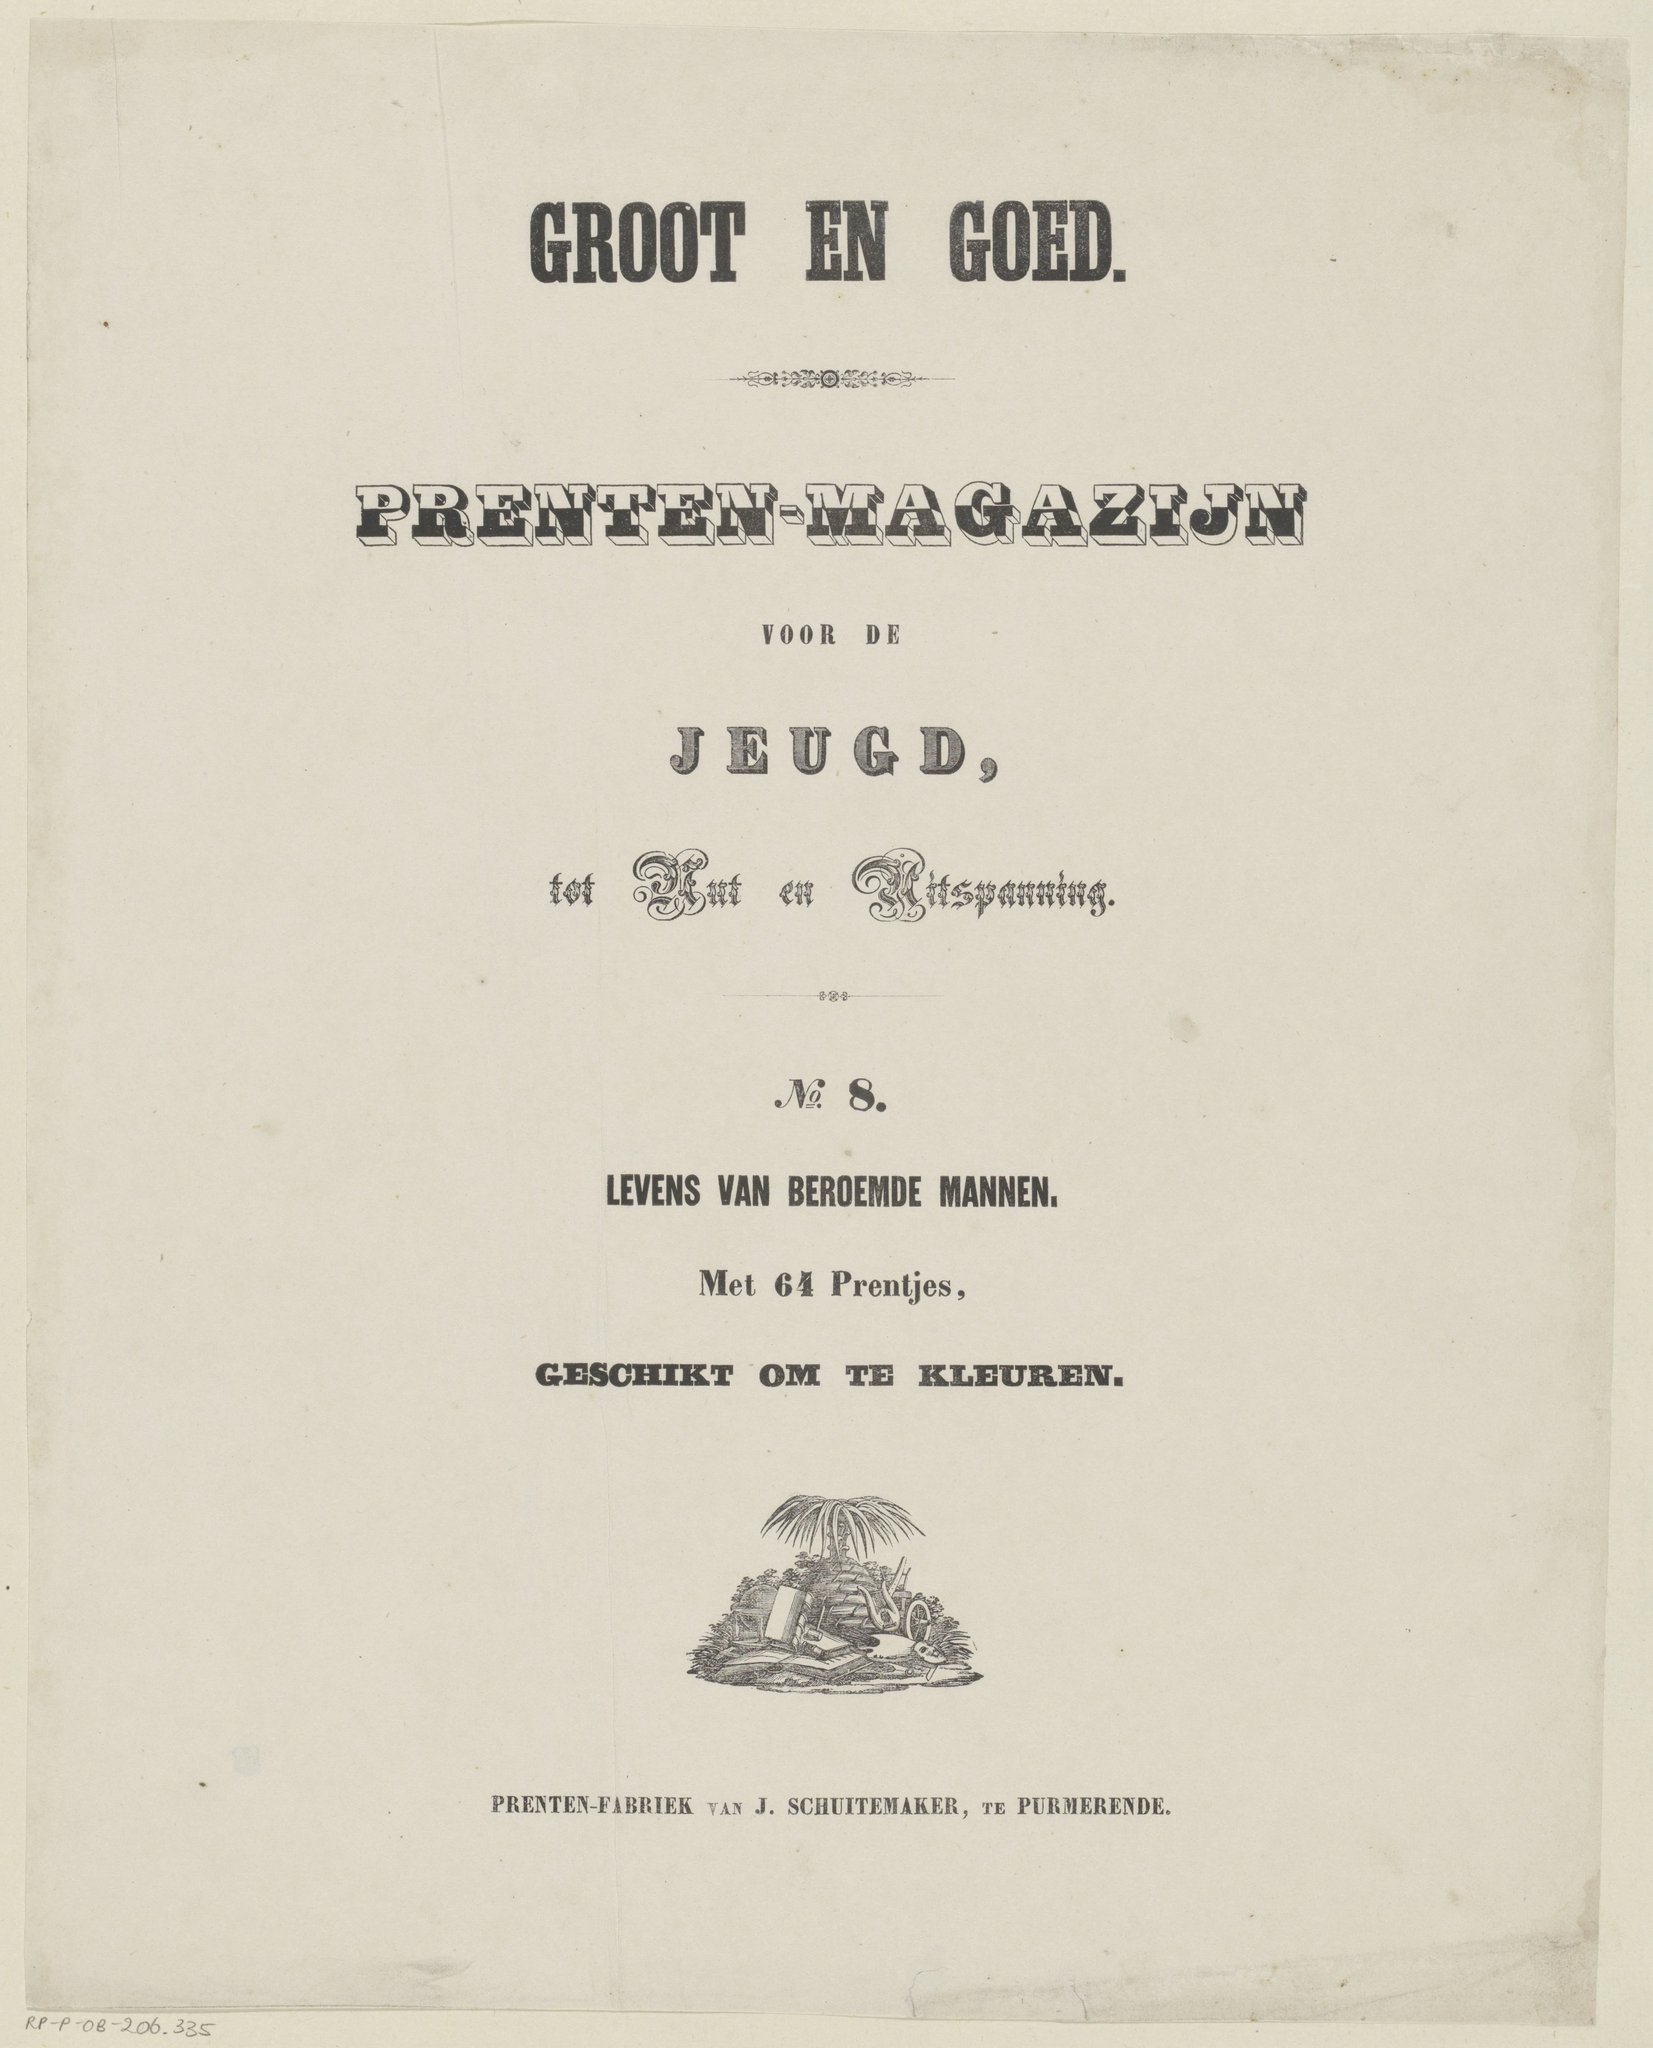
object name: titelblad, titelpagina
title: Groot en goed. / Prenten-magazijn voor de jeugd, tot nut en ontspanning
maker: jan schuitemaker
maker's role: draughtsman, publisher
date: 1842-1857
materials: paper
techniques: letterpress printing, engraving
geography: purmerend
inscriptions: collector's mark: Lugt 2760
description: Titelpagina voor 64 prenten uit de reeks: prenten-magazijn voor de jeugd, met als thema levens van beroemde mannen. Genummerd: No. 8. Blad aan één zijde bedrukt.